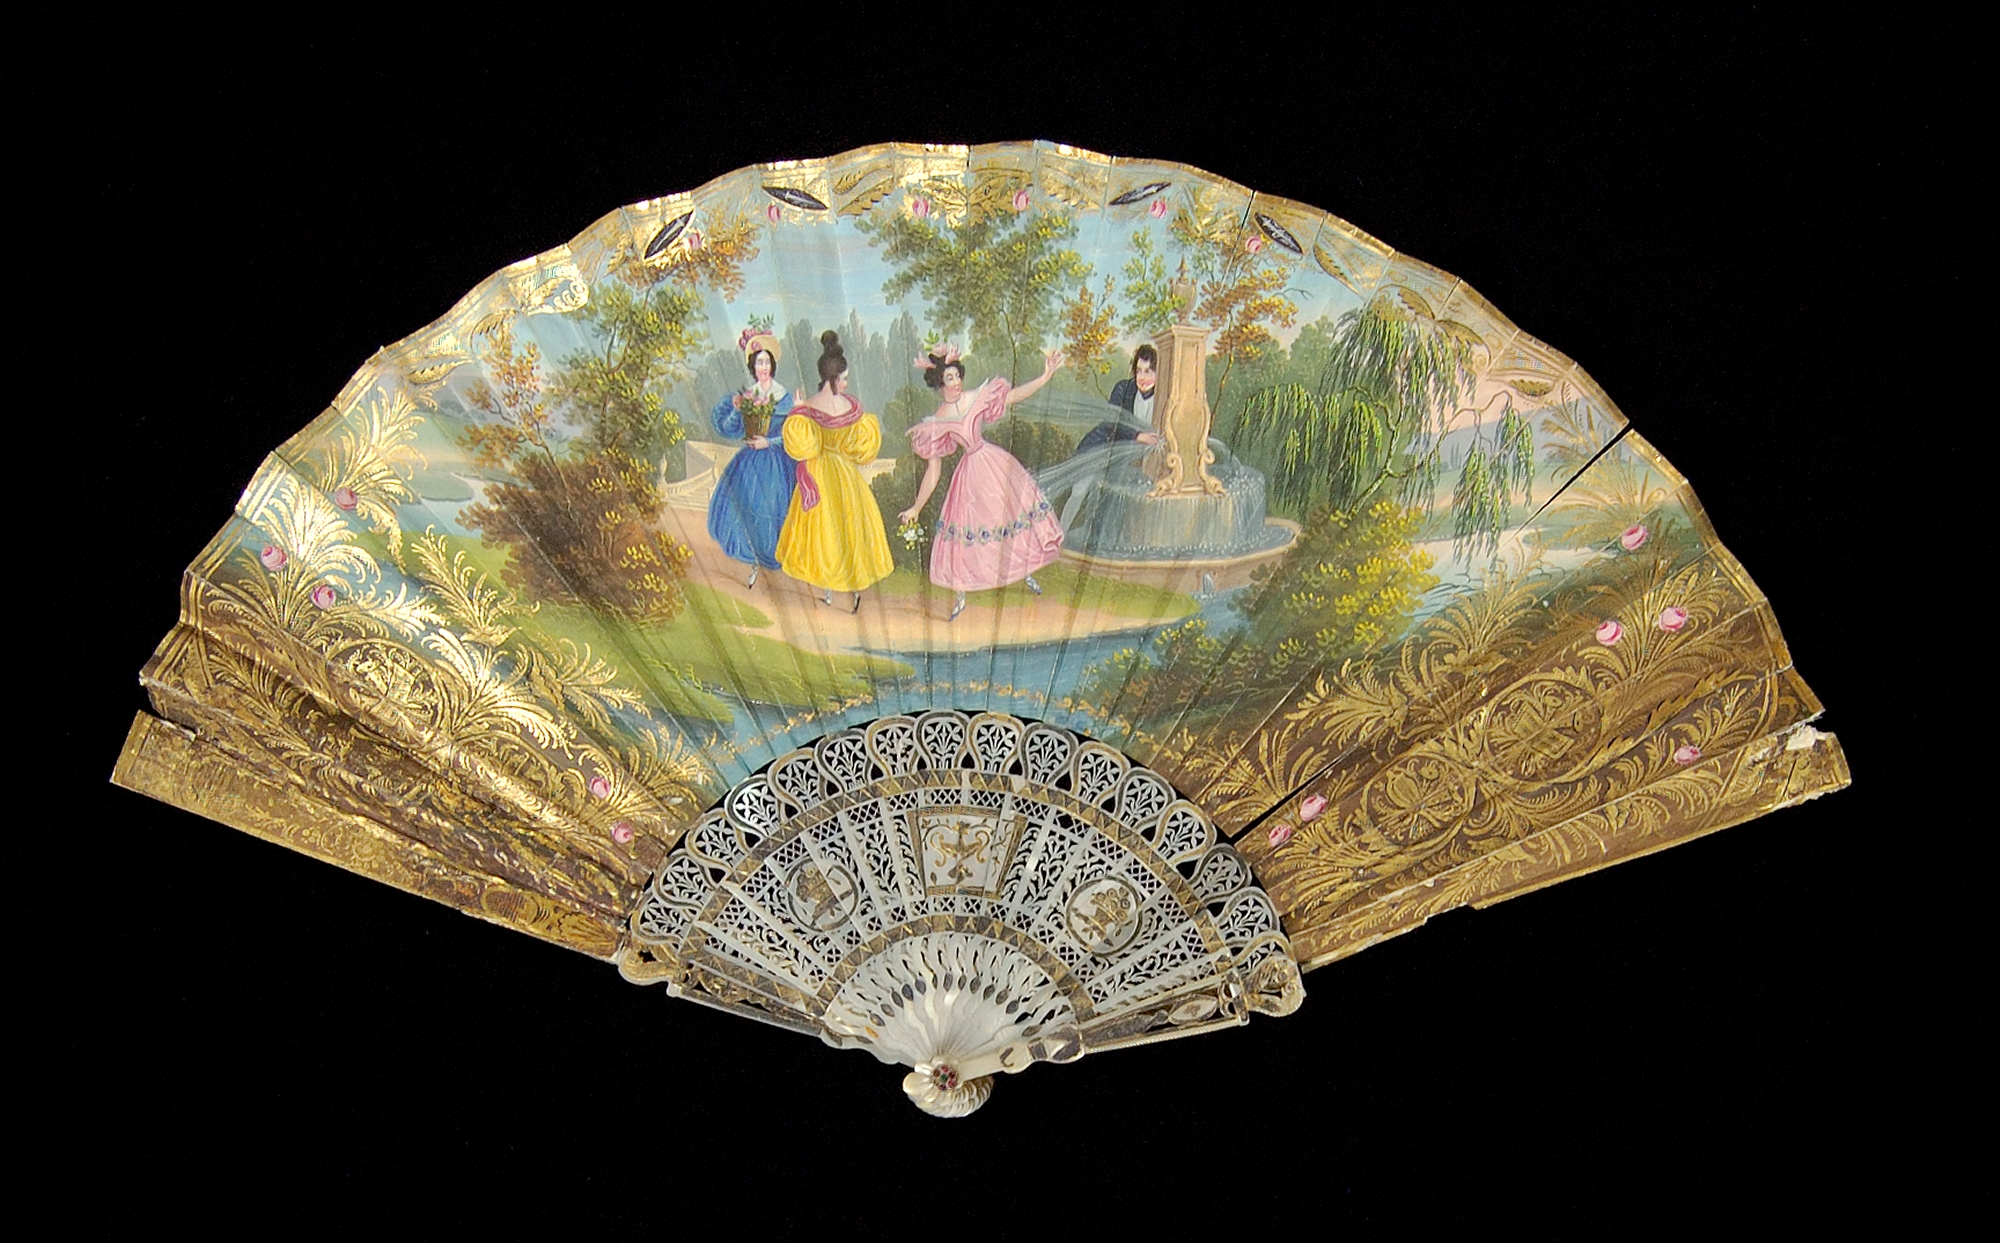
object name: fan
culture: european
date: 1830-1850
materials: mother of pearl, paper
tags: fountains,men,women